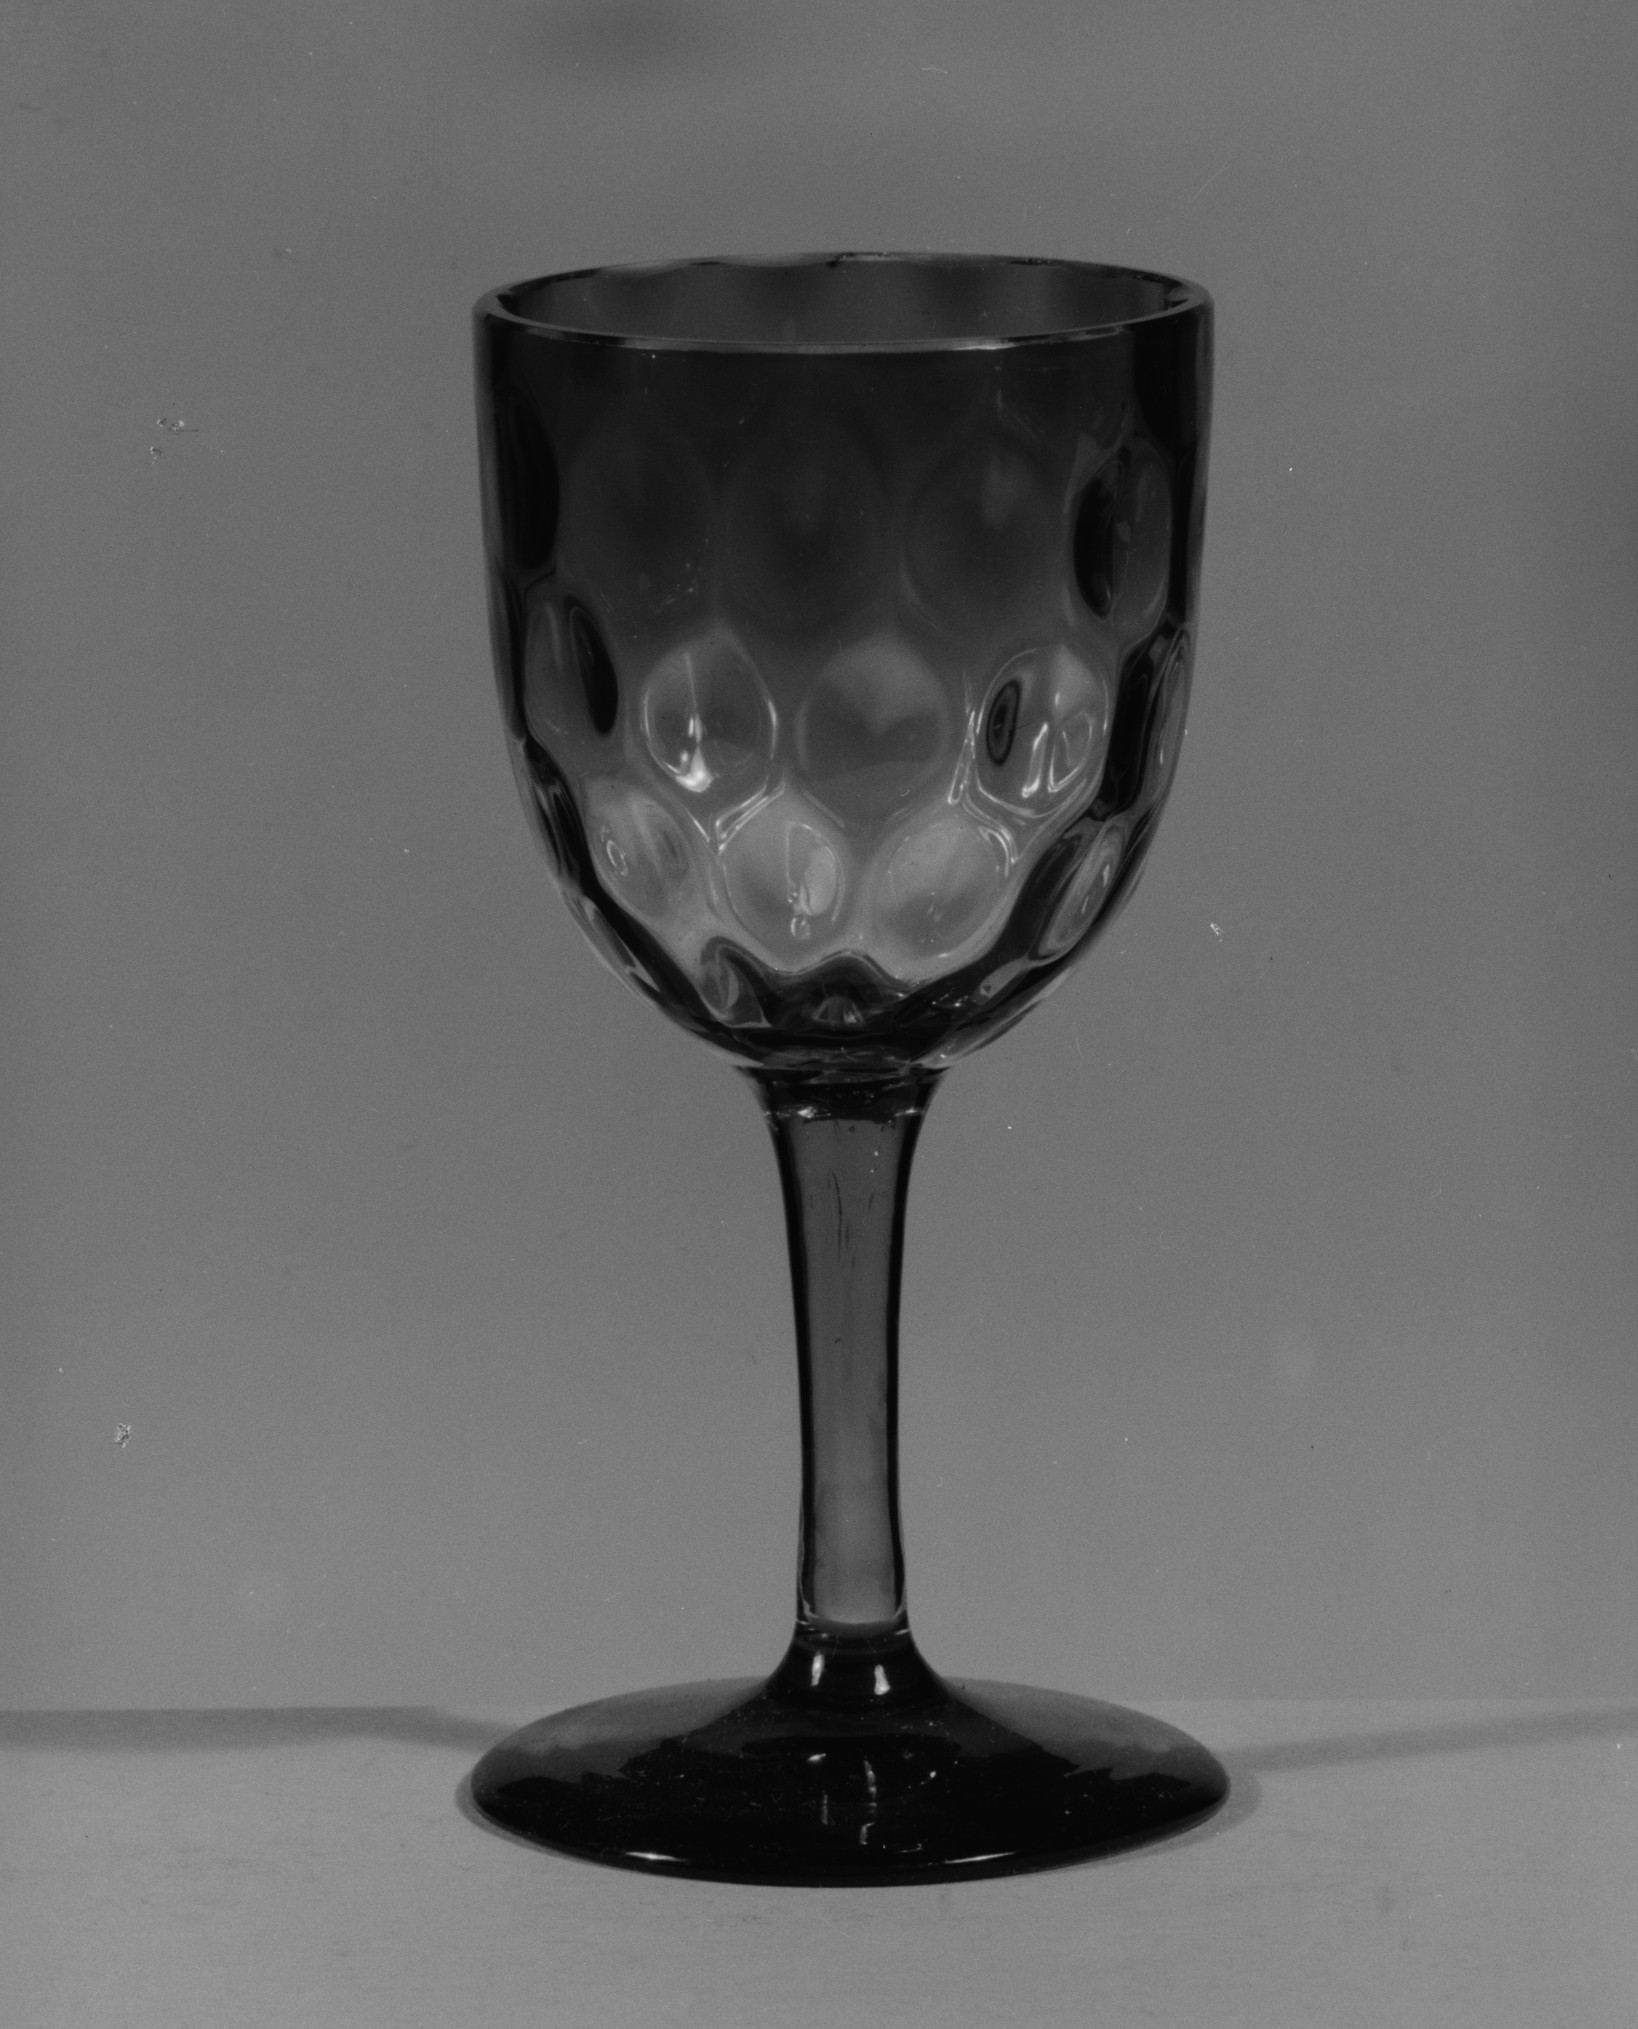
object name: cordial glass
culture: american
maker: hobbs, brockunier and company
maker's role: maker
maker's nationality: american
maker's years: 1863-1891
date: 1885-1887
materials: glass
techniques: glassblowing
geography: united states